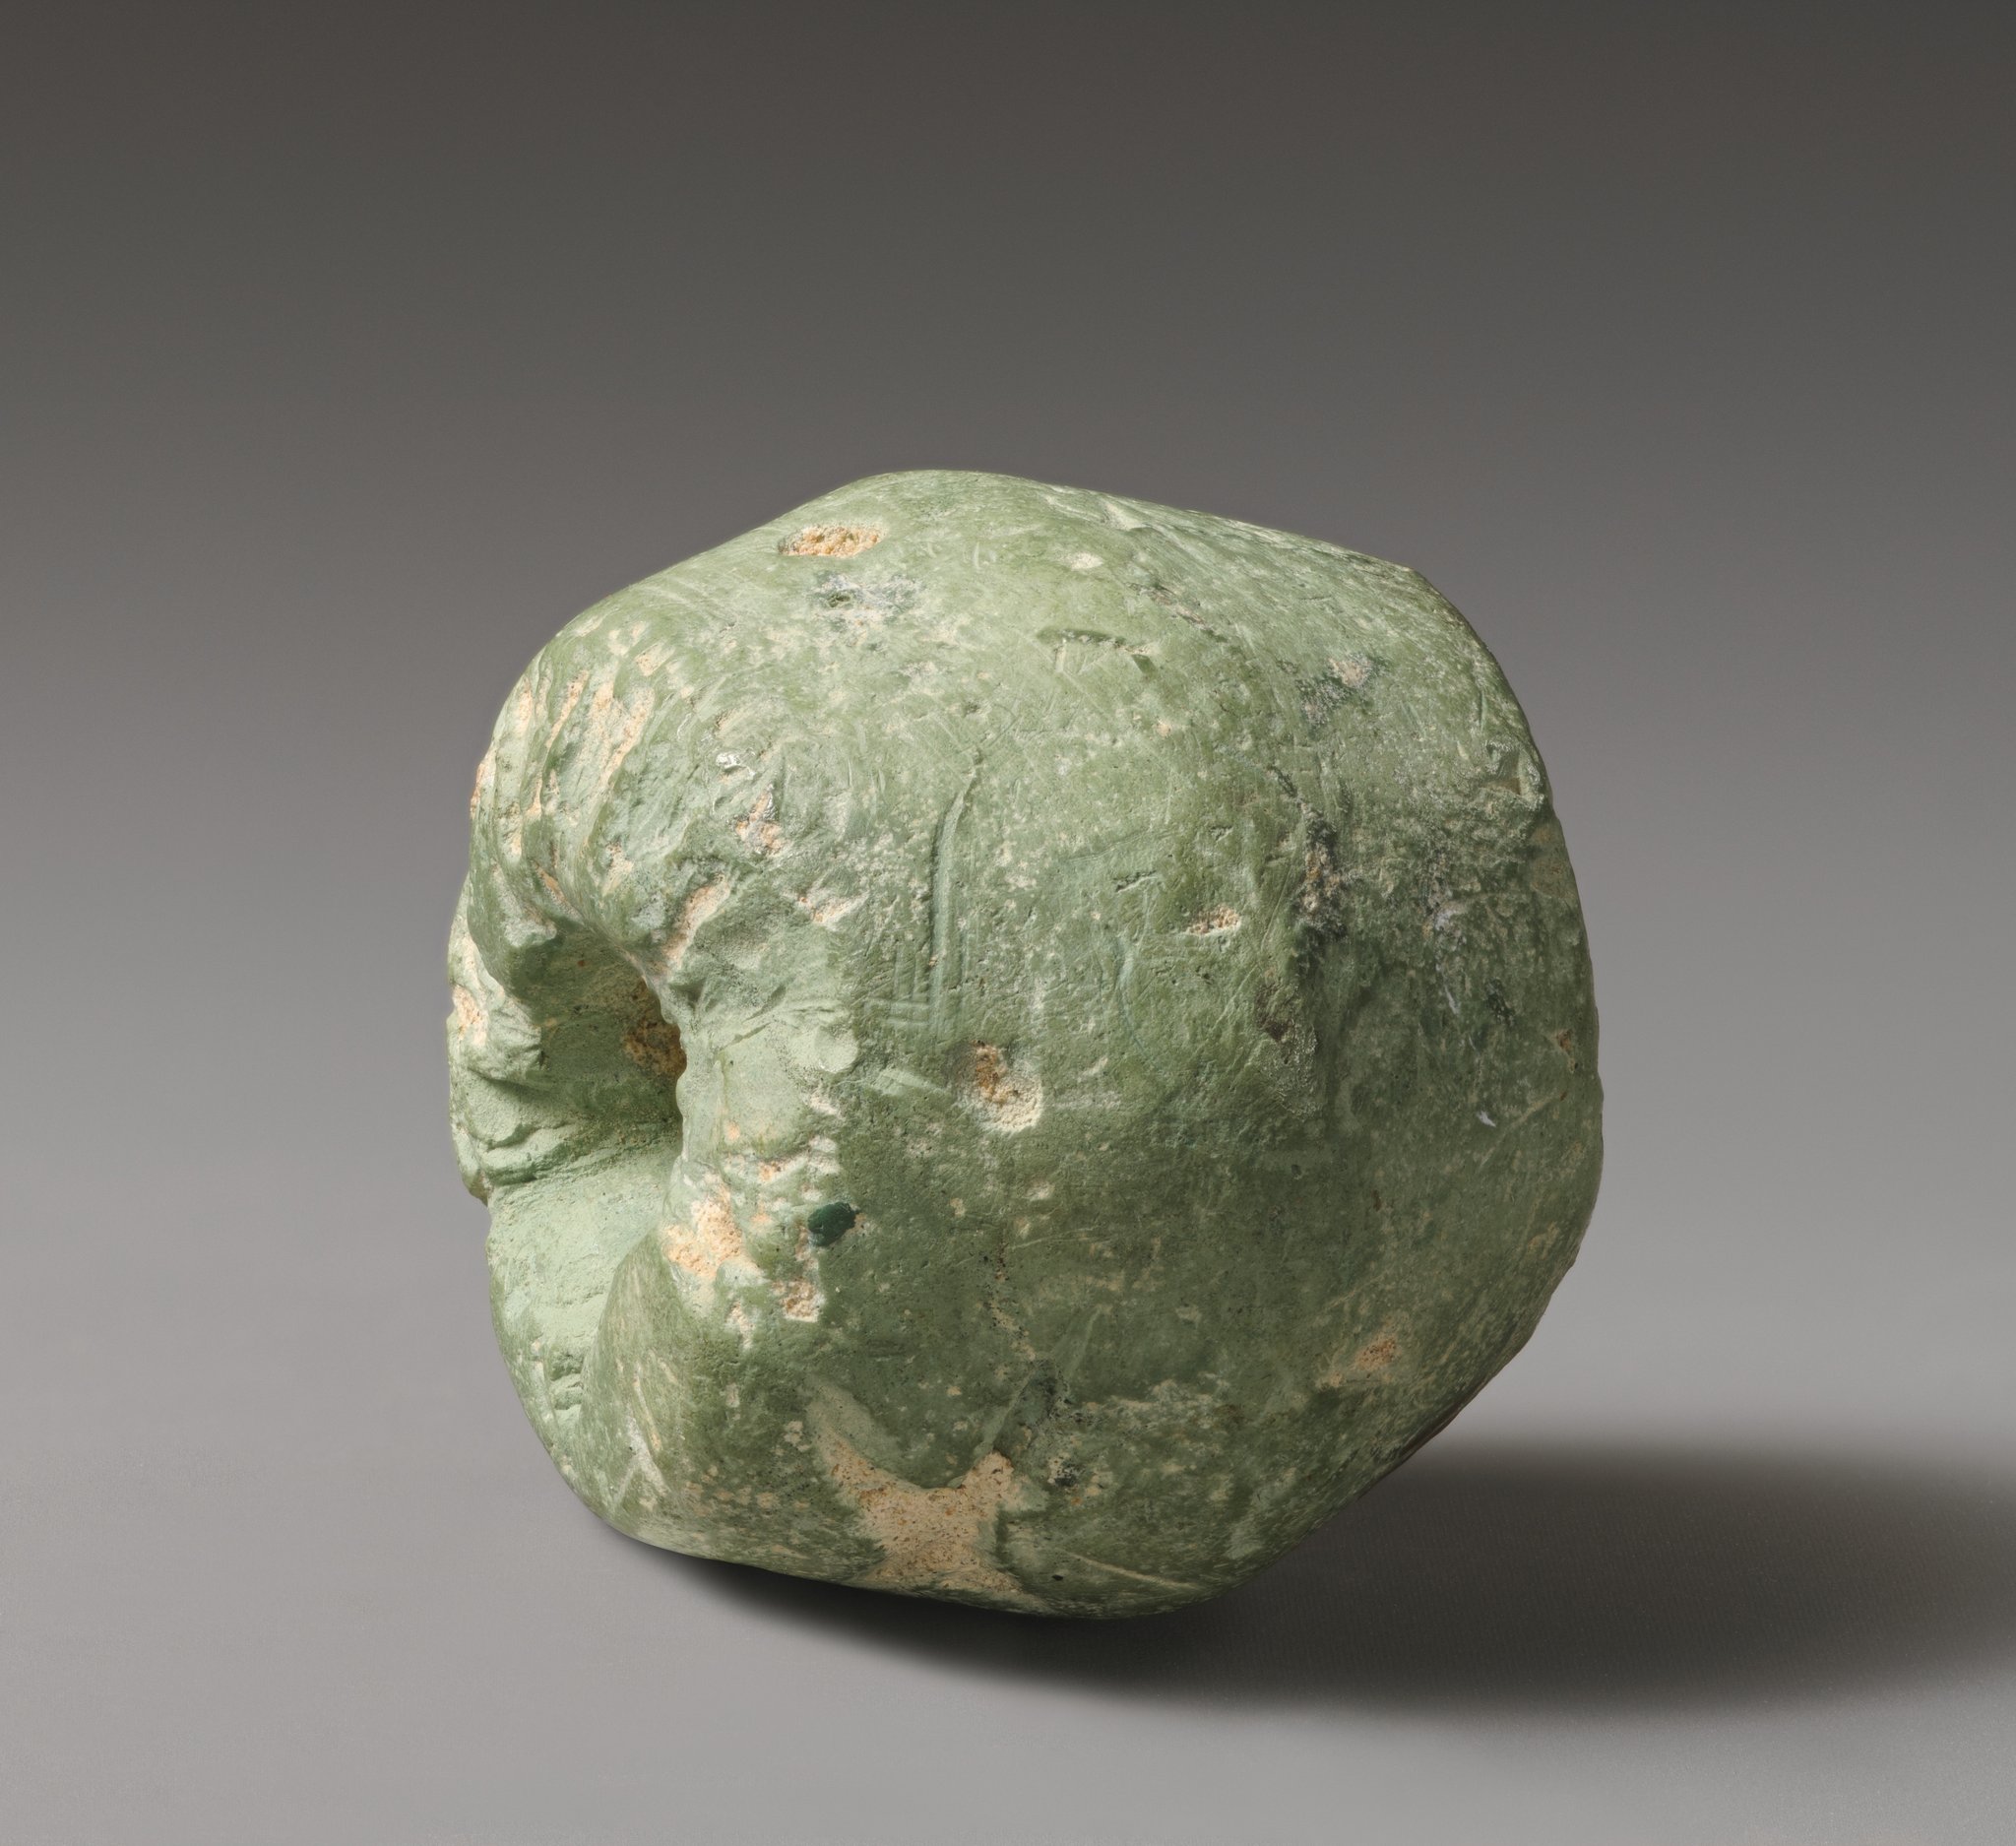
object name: spindle whorl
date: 4000-3001 BCE